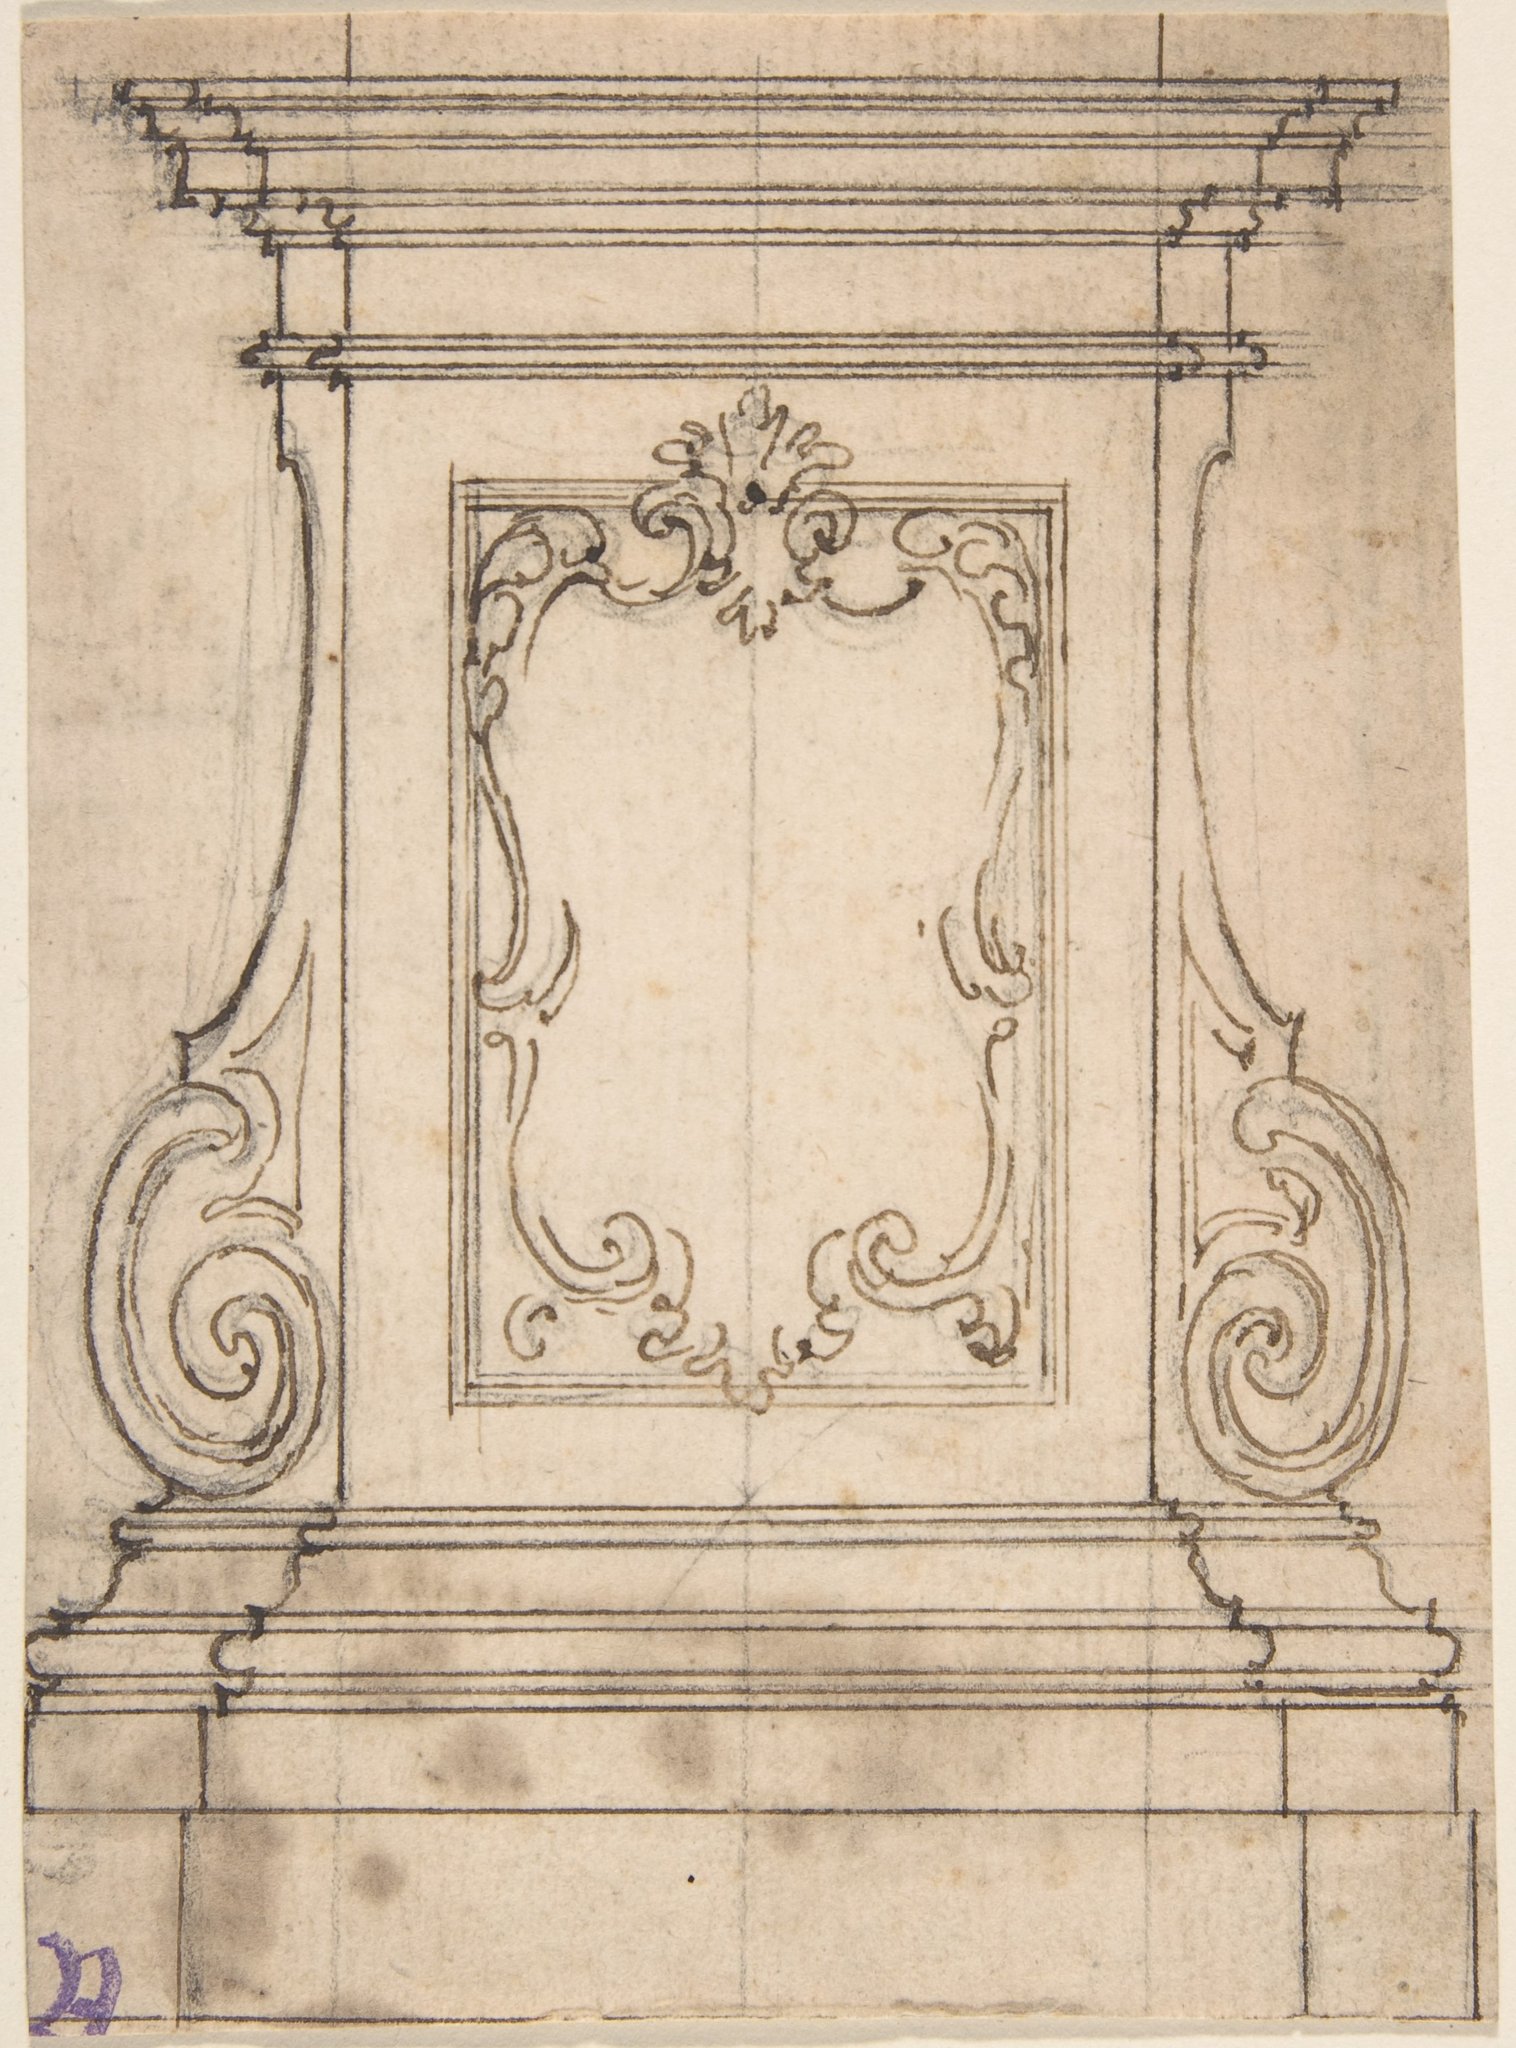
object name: drawing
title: Design for a Pedestal (recto); Design for the Plan of a Monument (verso)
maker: giovanni battista foggini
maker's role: artist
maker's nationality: italian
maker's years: 1652-1725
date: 1672-1725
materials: chalk, ink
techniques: pen